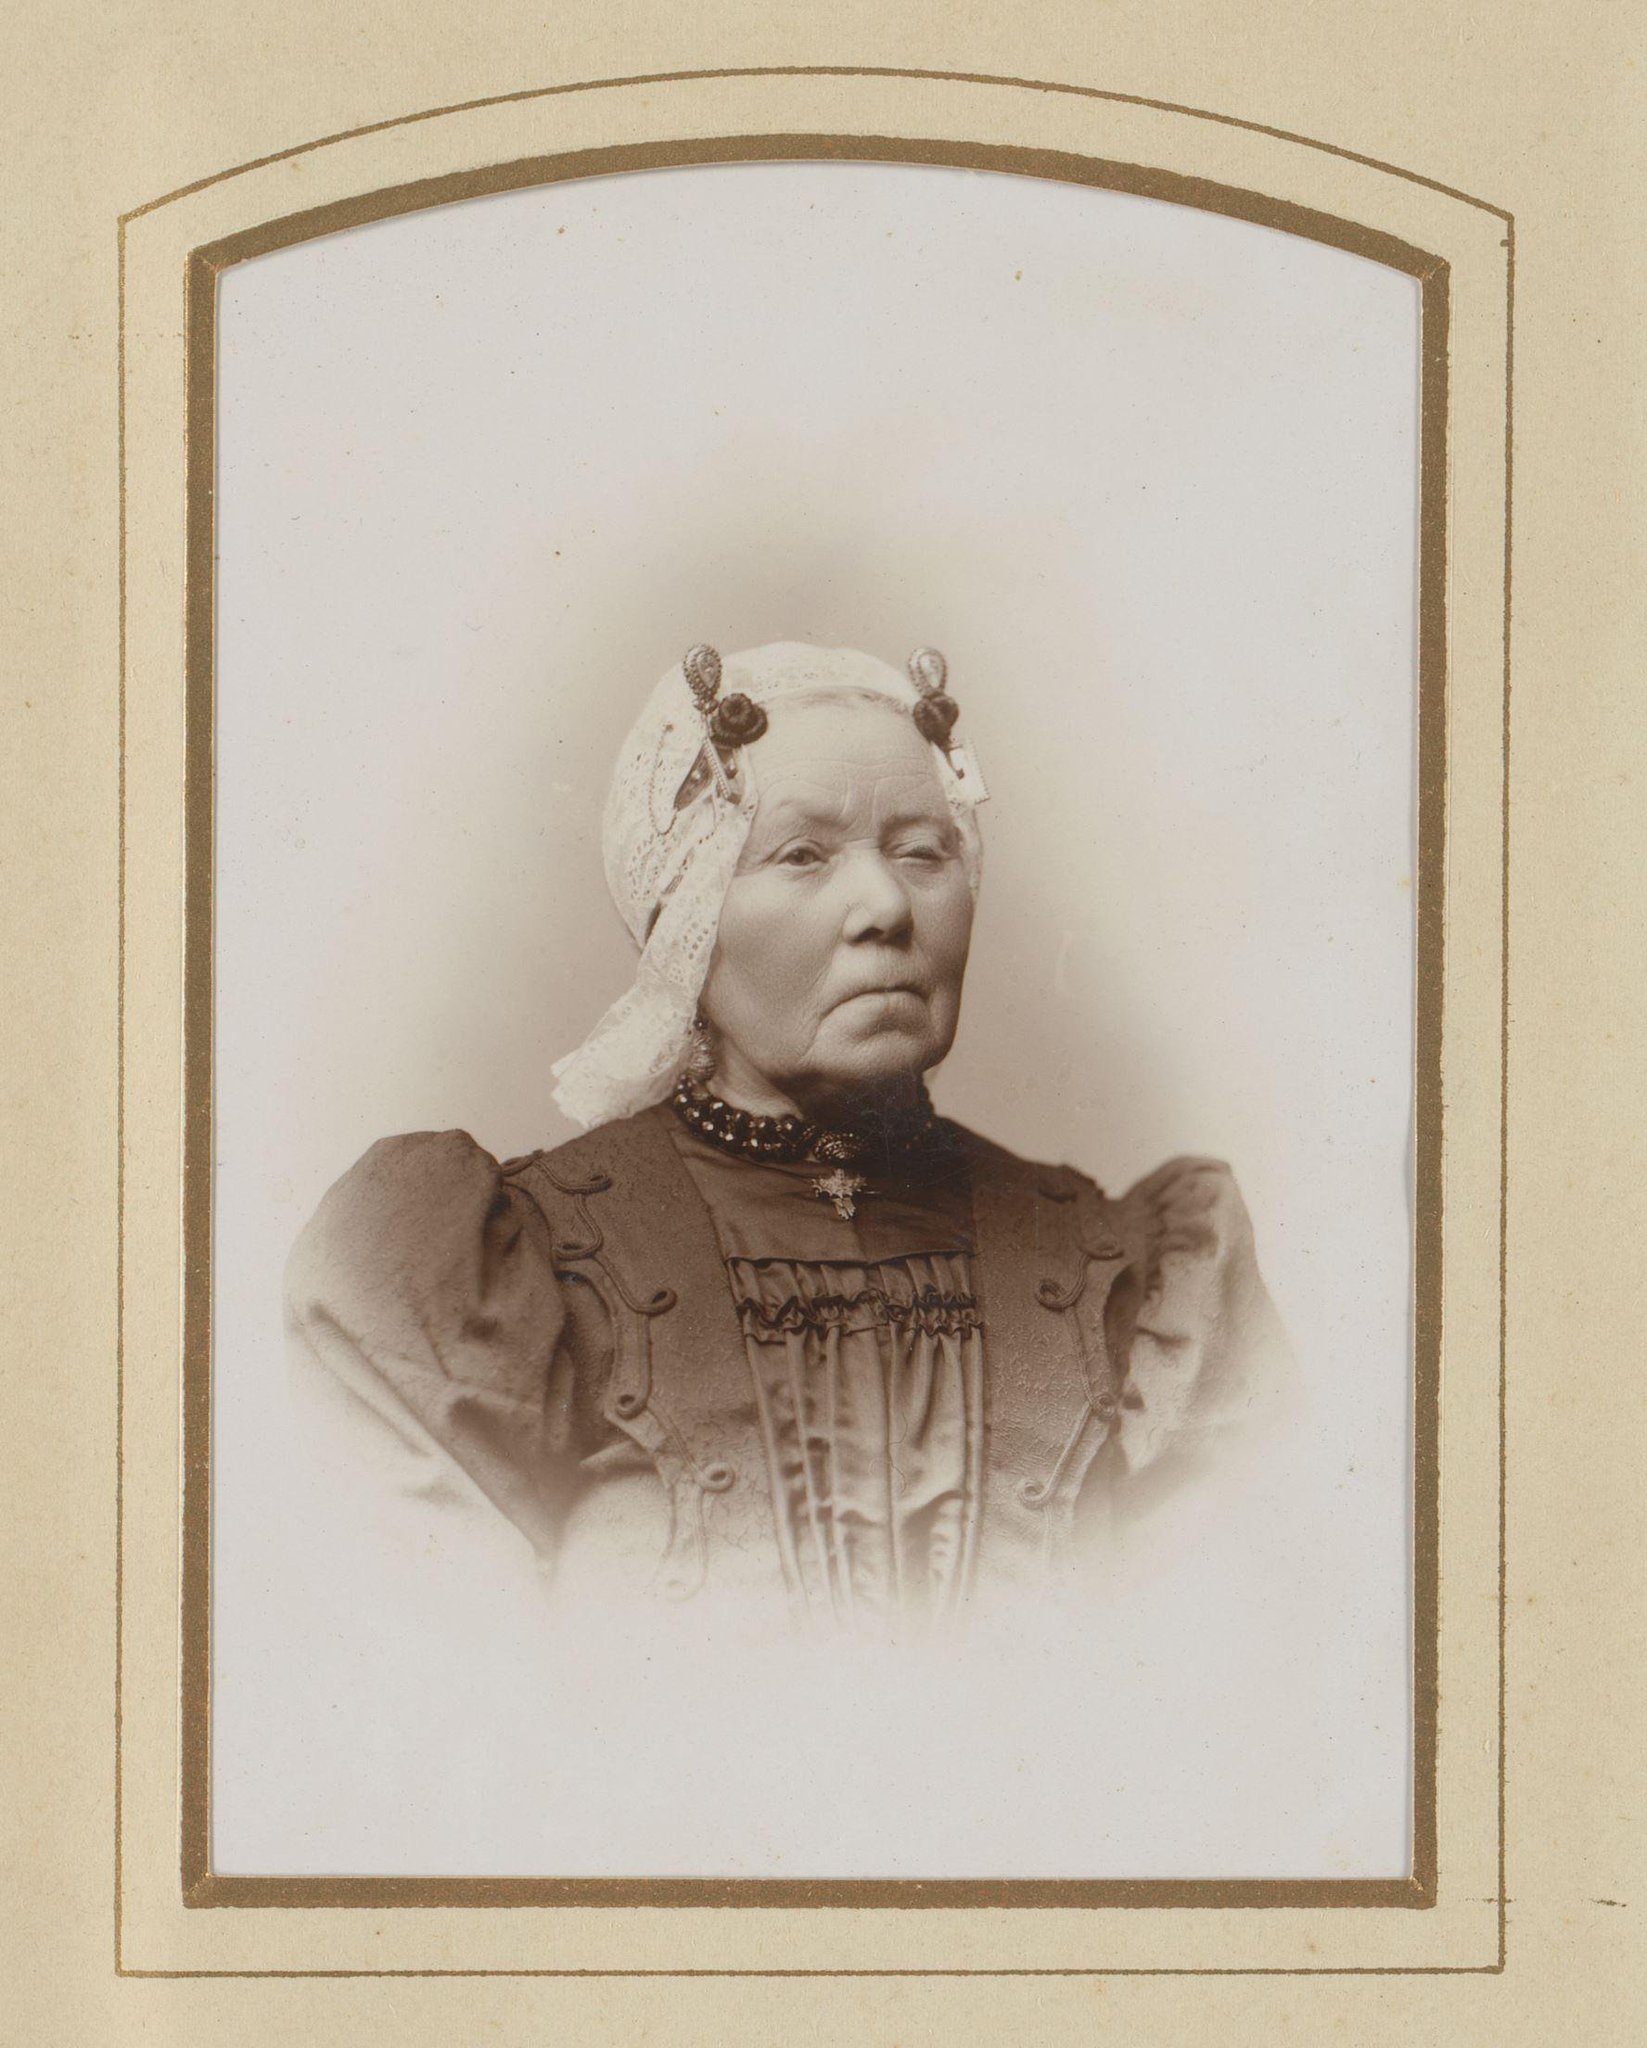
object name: cabinet photograph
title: Portret van een vrouw met witte klederdrachtmuts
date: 1885-1906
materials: cardboard, photographic support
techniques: gelatin silver print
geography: amsterdam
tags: historical persons - bb - woman, head-gear: cap, folk costume, regional costume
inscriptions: inscription: ‘OPGERICHT 1864/ Amsterdam/ Westermarkt 19/ W. G. Kuijer & Zonen/ Hofphotographen/ Speciale Inrichting/ voor/ VERGROOTINGEN/ in alle Formaten’